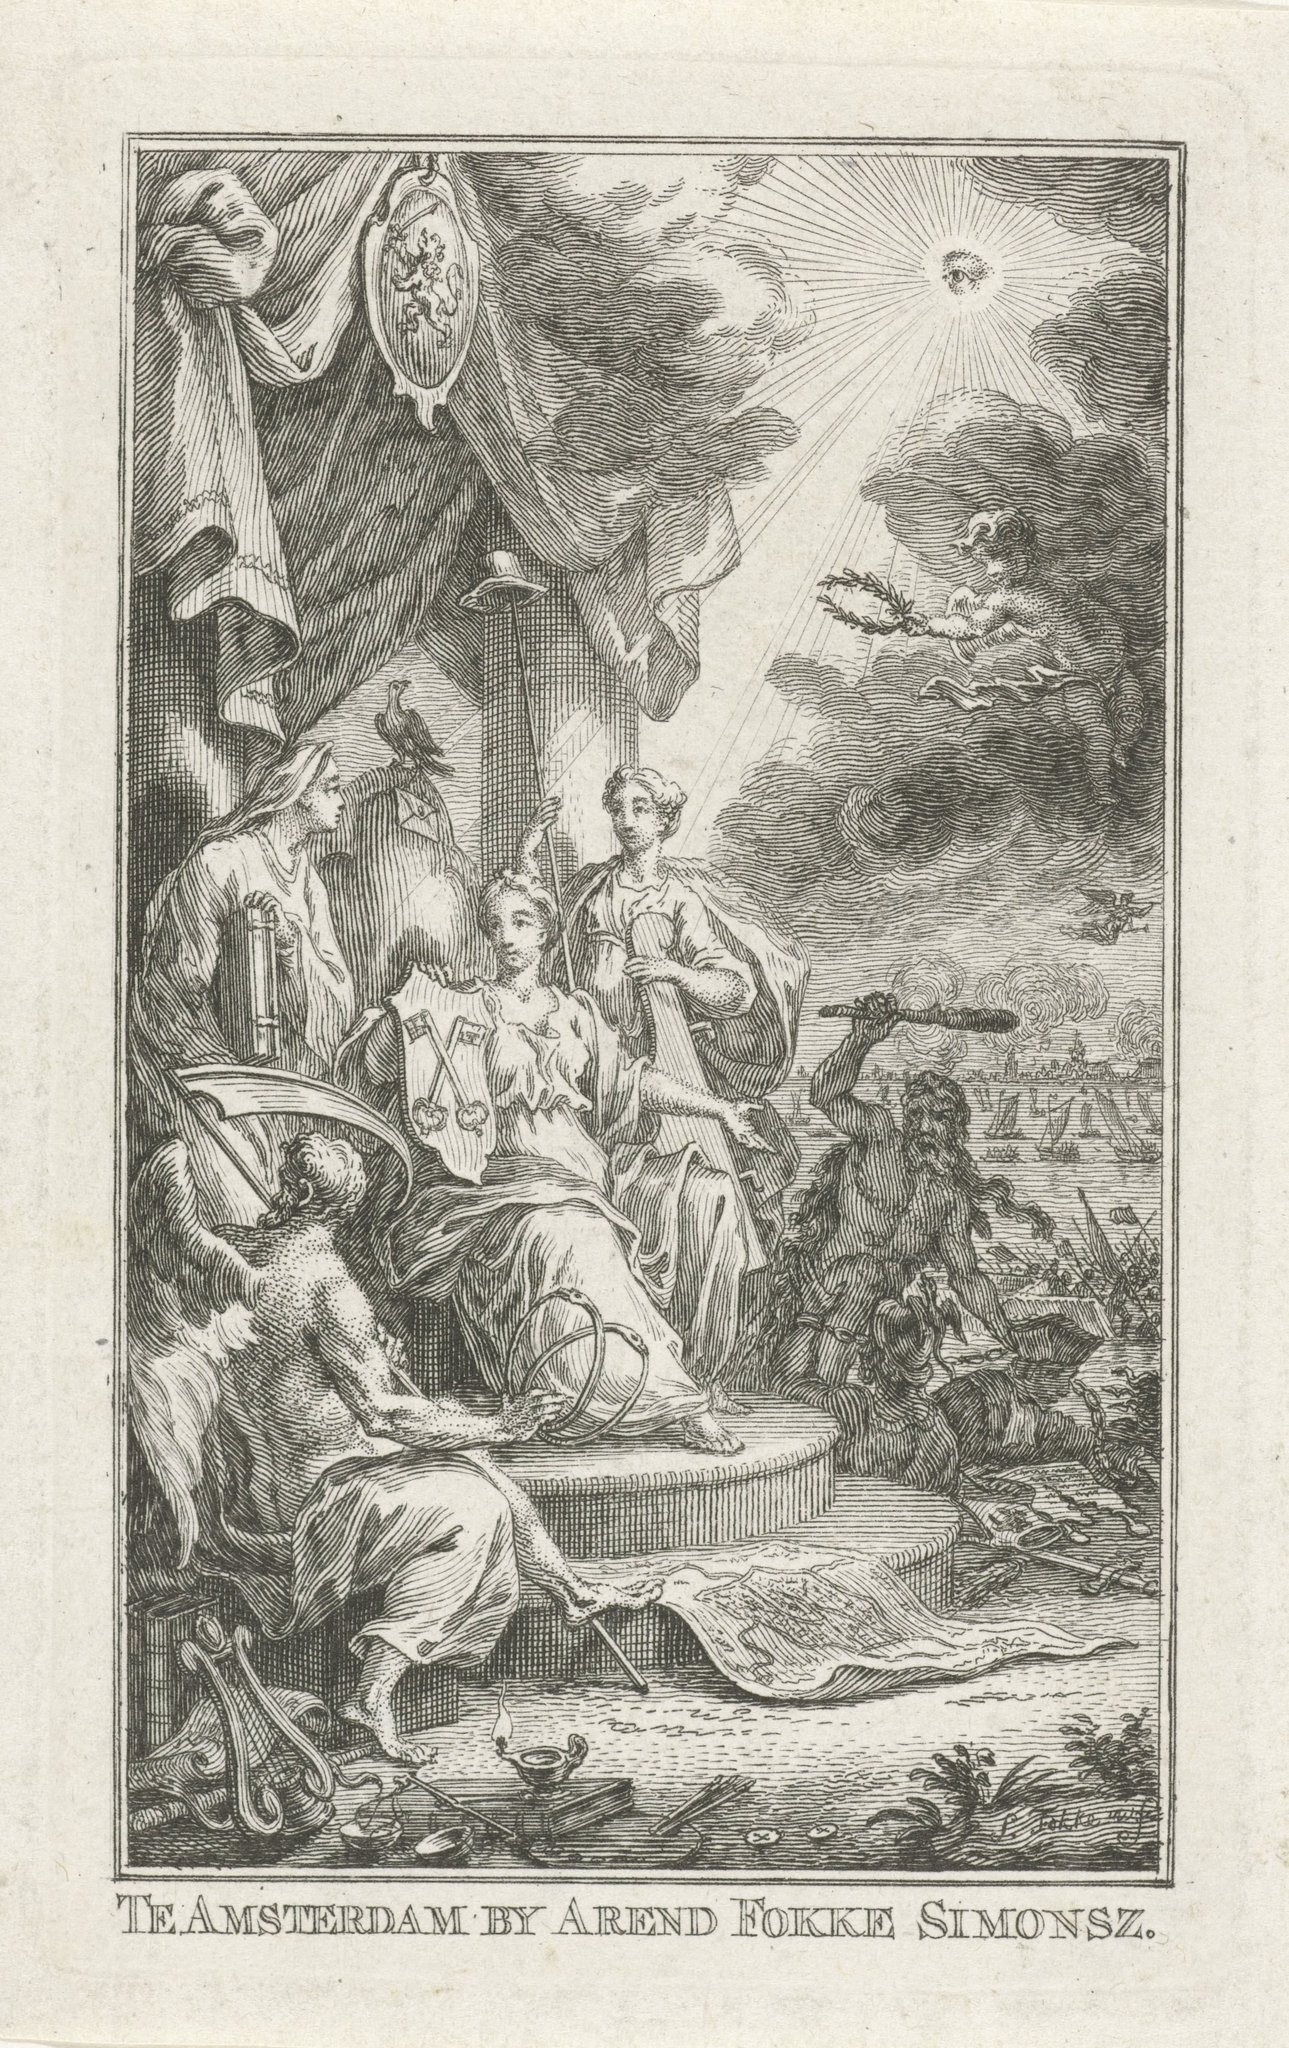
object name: print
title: Allegorie op het Tweede Eeuwfeest van het Leids Ontzet, 1774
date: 1774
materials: paper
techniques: engraving, etching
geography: northern netherlands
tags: personification of a city, town-patron(ess), father time, man with wings and scythe, leiden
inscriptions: collector's mark: Lugt 2228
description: Allegorie op het Tweede Eeuwfeest van het ontzet van Leiden, 3 oktober 1774. De stadsmaagd van Leiden zittend op een troon, begeleid door de Vrijheid, de Tijd en de Historie. Op de achtergrond Hercules en het Leids Ontzet (1574).